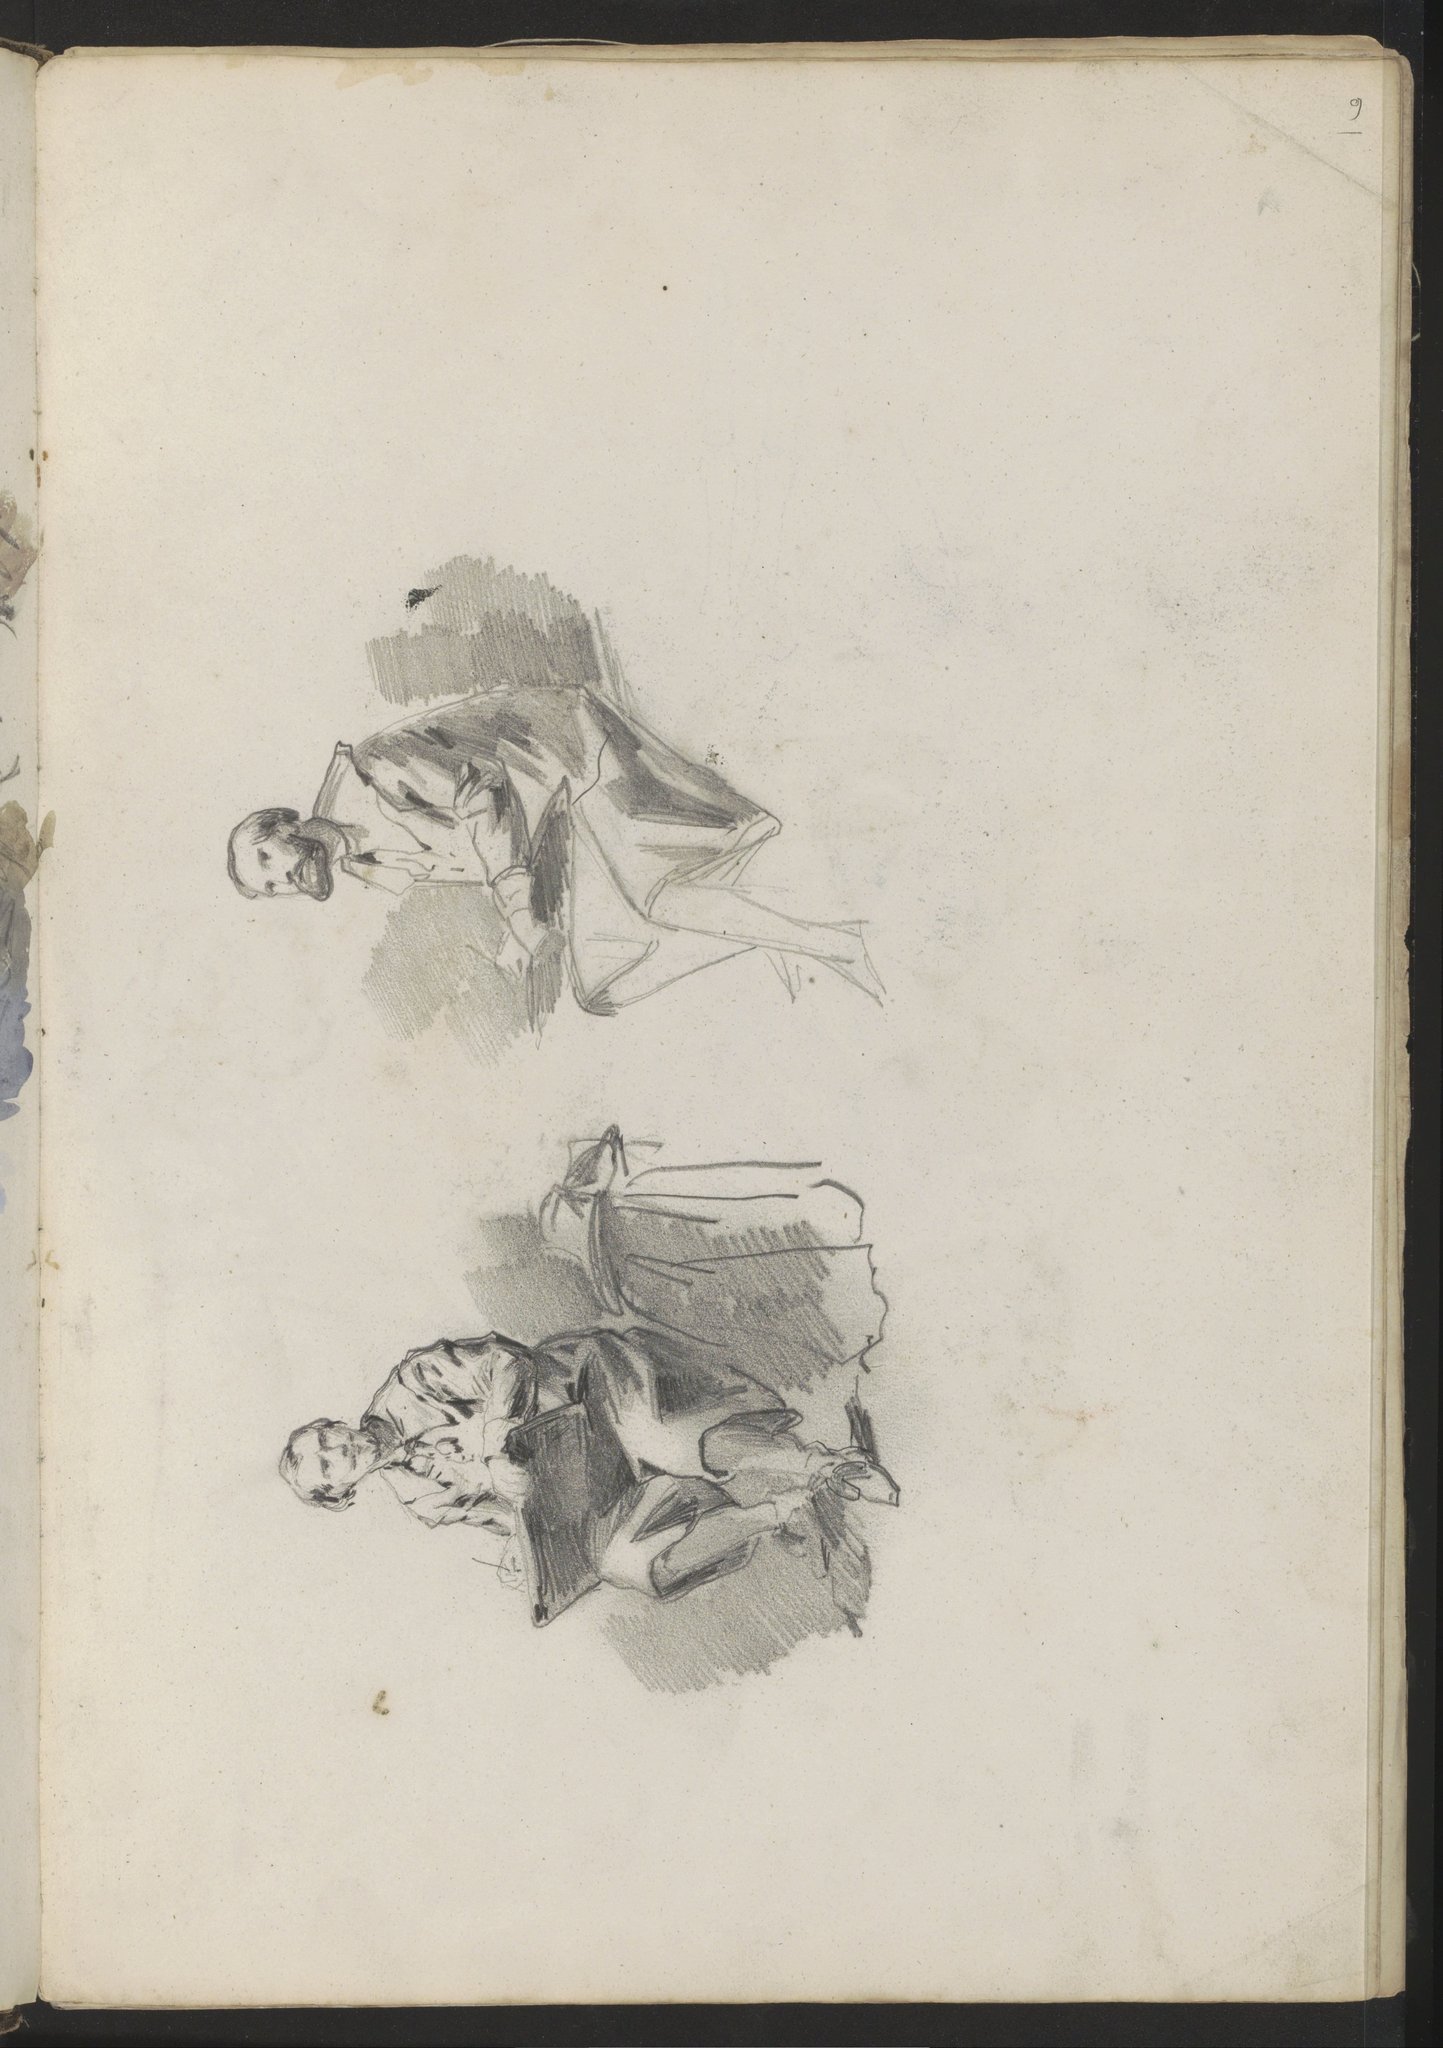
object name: sketchbook leaf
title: Twee schrijvende mannen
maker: johannes huybertus van hove bzn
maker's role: print maker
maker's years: 1827-1881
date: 1837-1881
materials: paper, pencil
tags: sitting figure, writing accessories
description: Blad 9 recto uit een schetsboek met 33 bladen en 10 losse tekeningen.